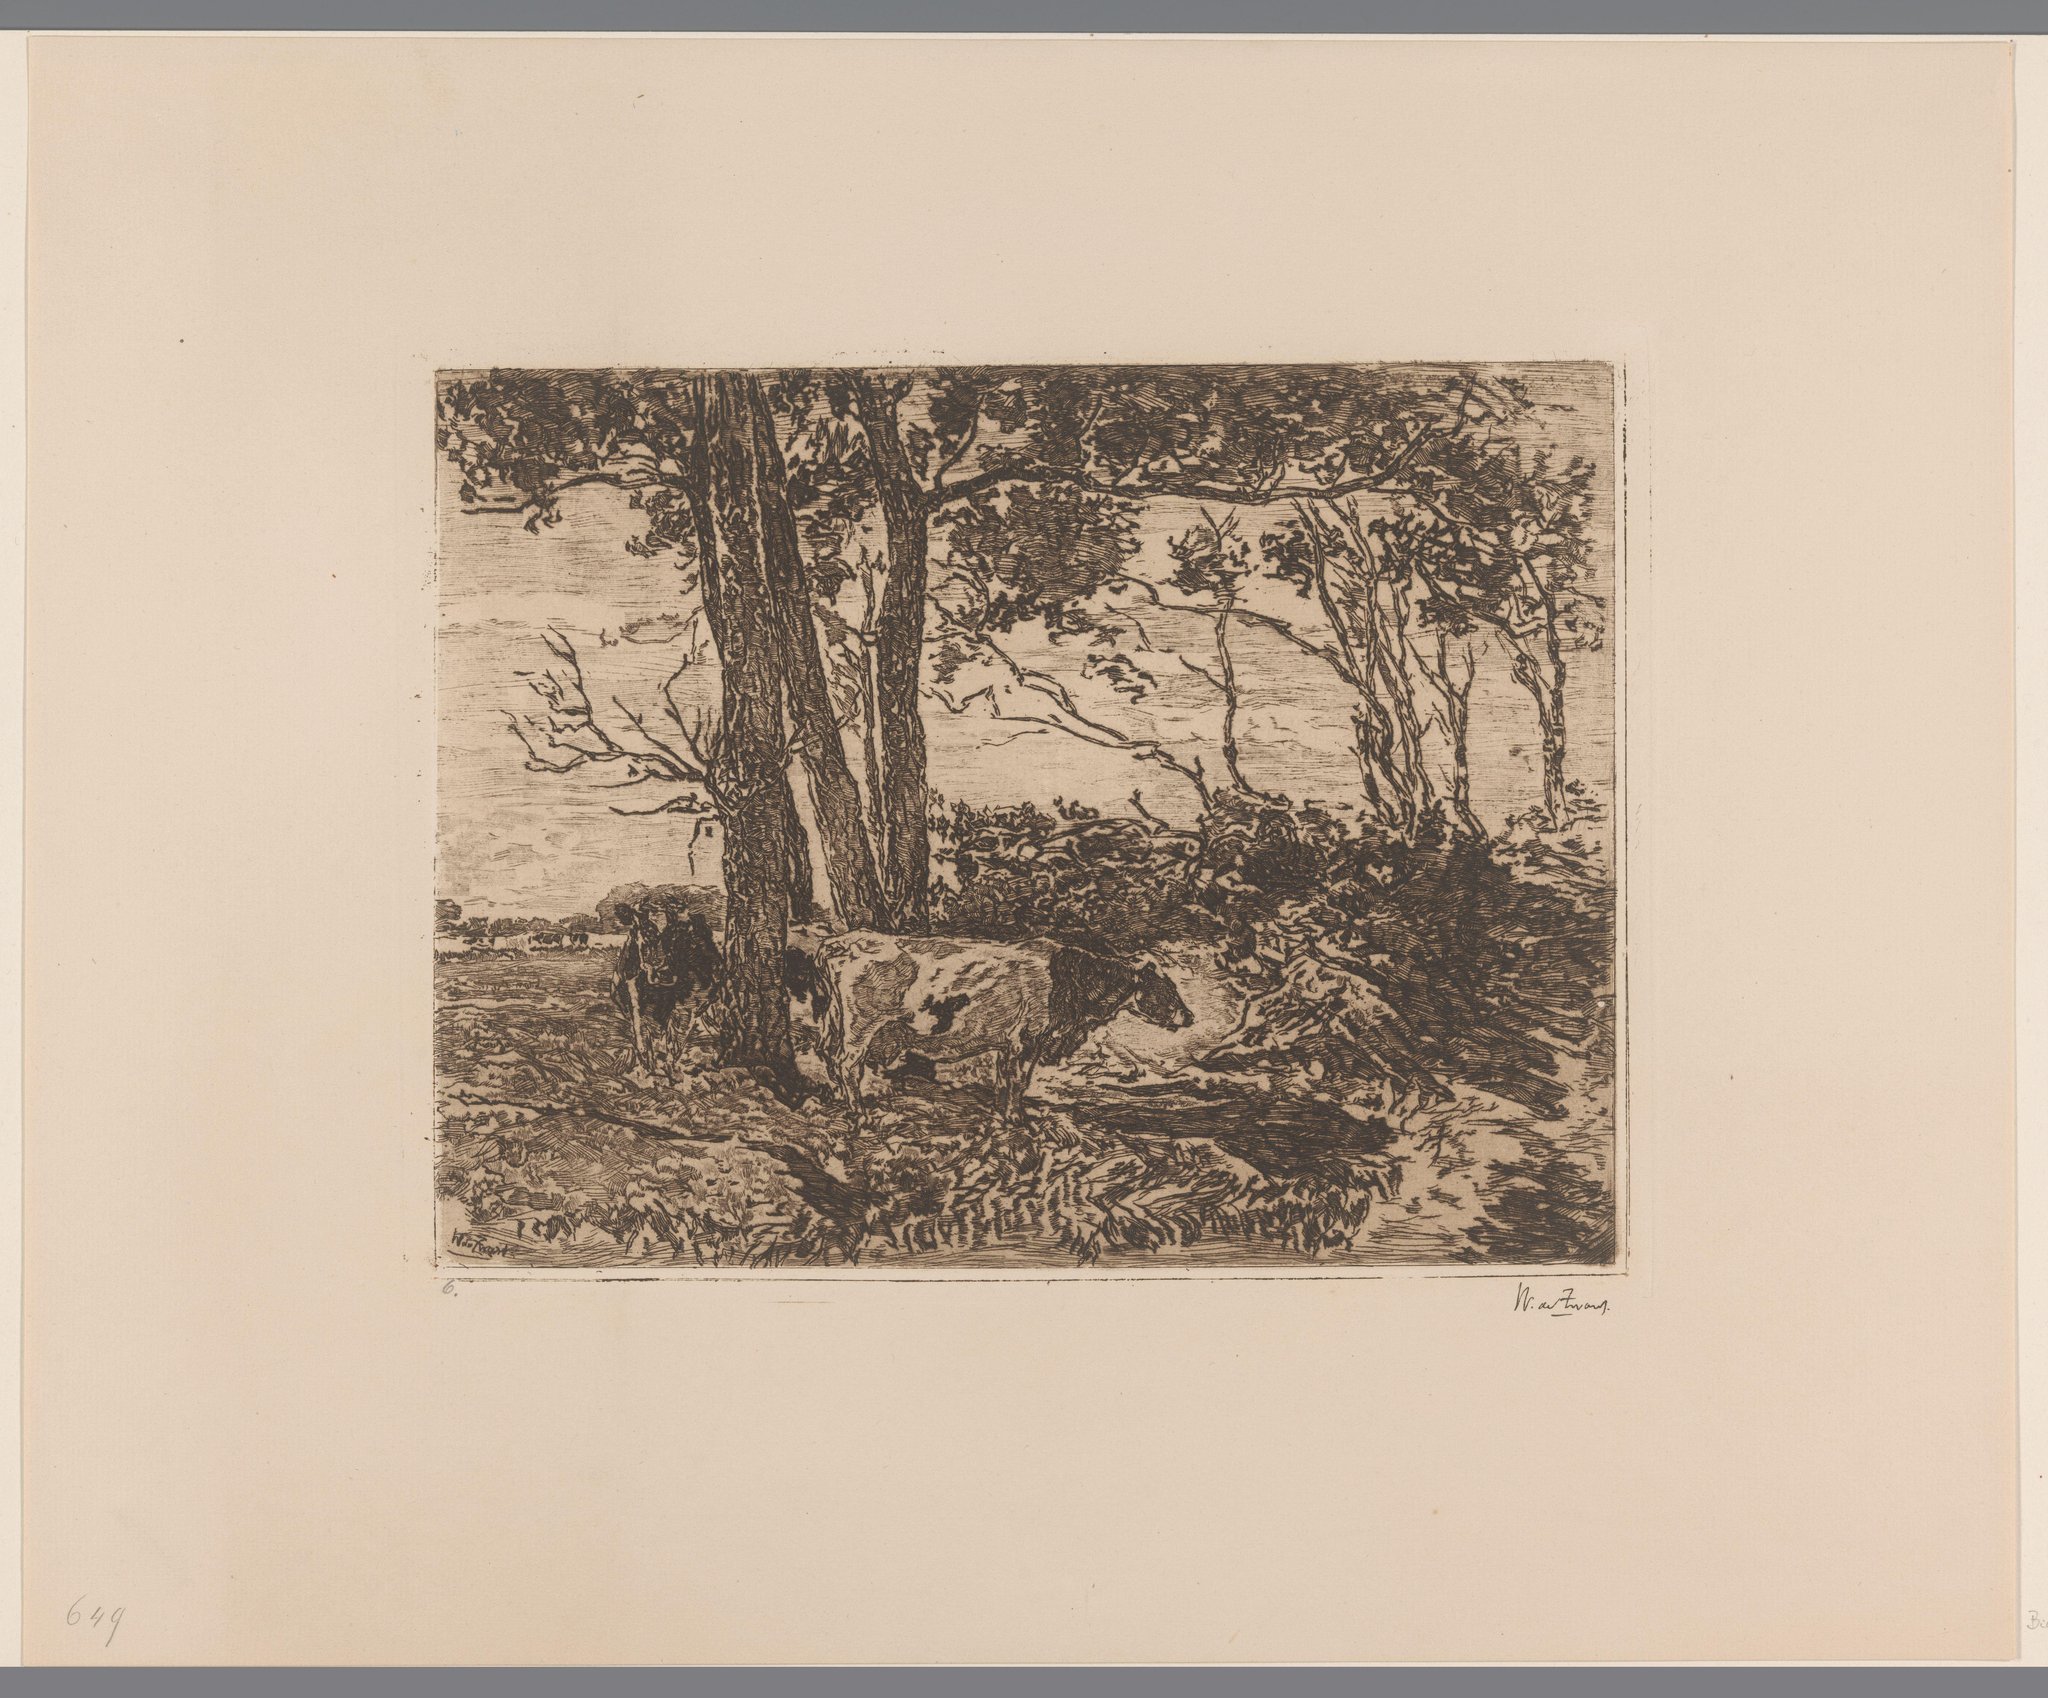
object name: print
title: Koeien onder bomen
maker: willem de zwart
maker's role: draughtsman, painter, print maker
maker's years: 1862-1931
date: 1905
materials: paper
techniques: etching, intaglio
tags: cow, landscapes in the temperate zone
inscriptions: collector's mark: Lugt 2760, collector's mark: Lugt 2228